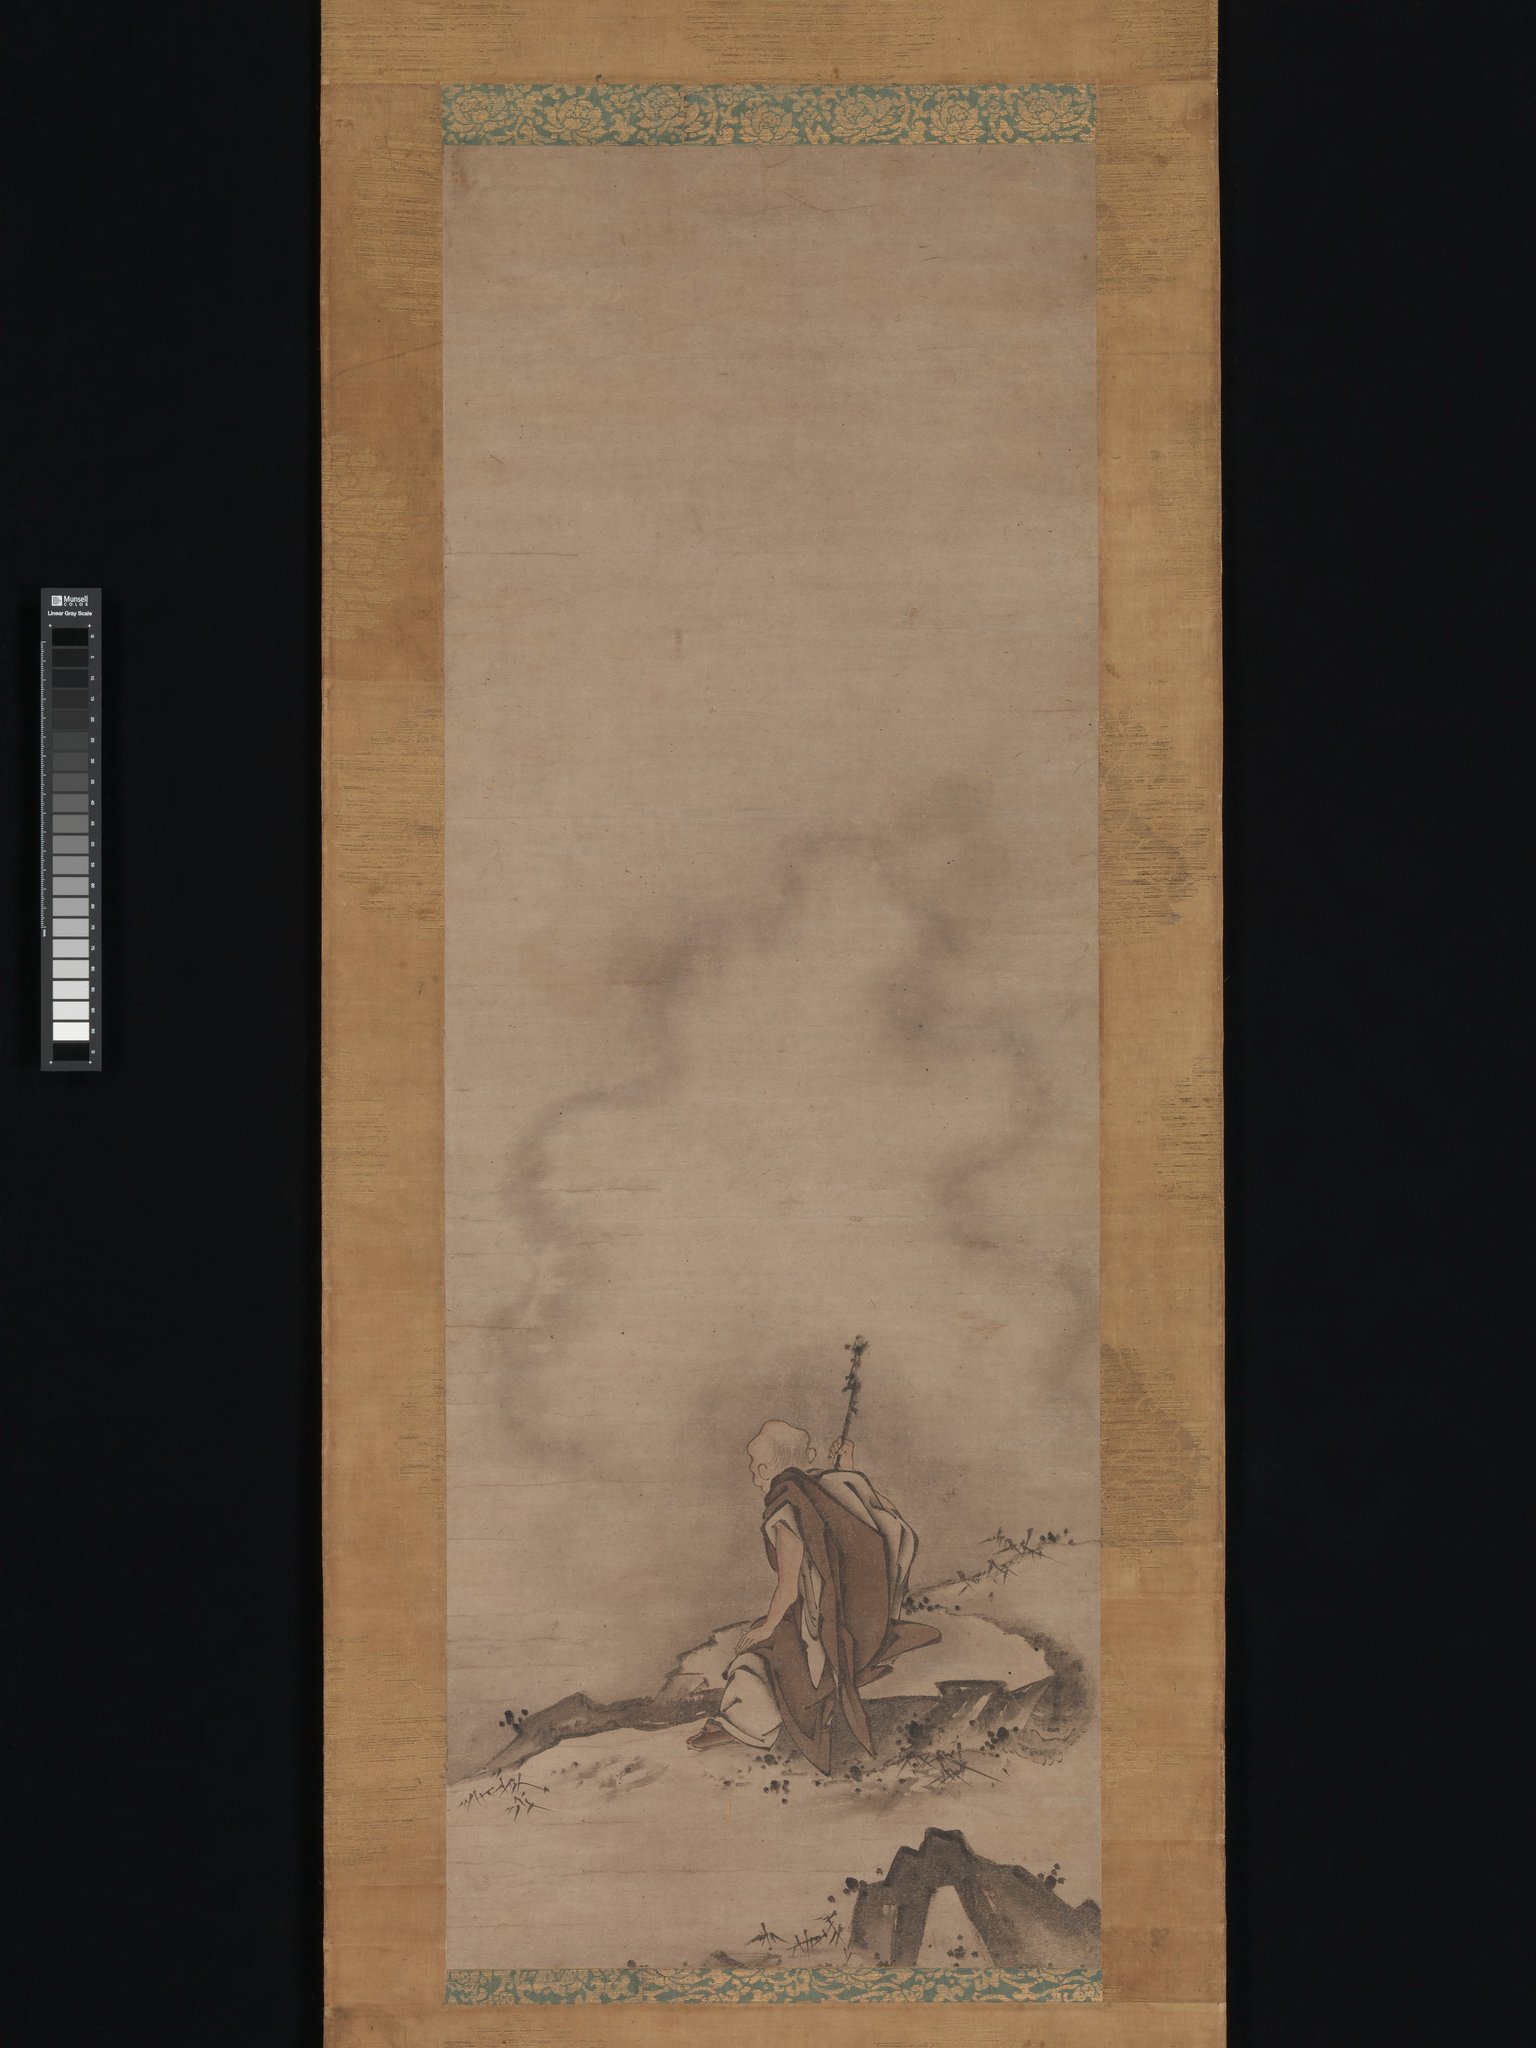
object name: hanging scroll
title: Fenggan, Hanshan, and Shide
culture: japanese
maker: reisai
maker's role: artist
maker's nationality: japanese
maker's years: 1430-1450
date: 1401-1450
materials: ink, paper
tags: men